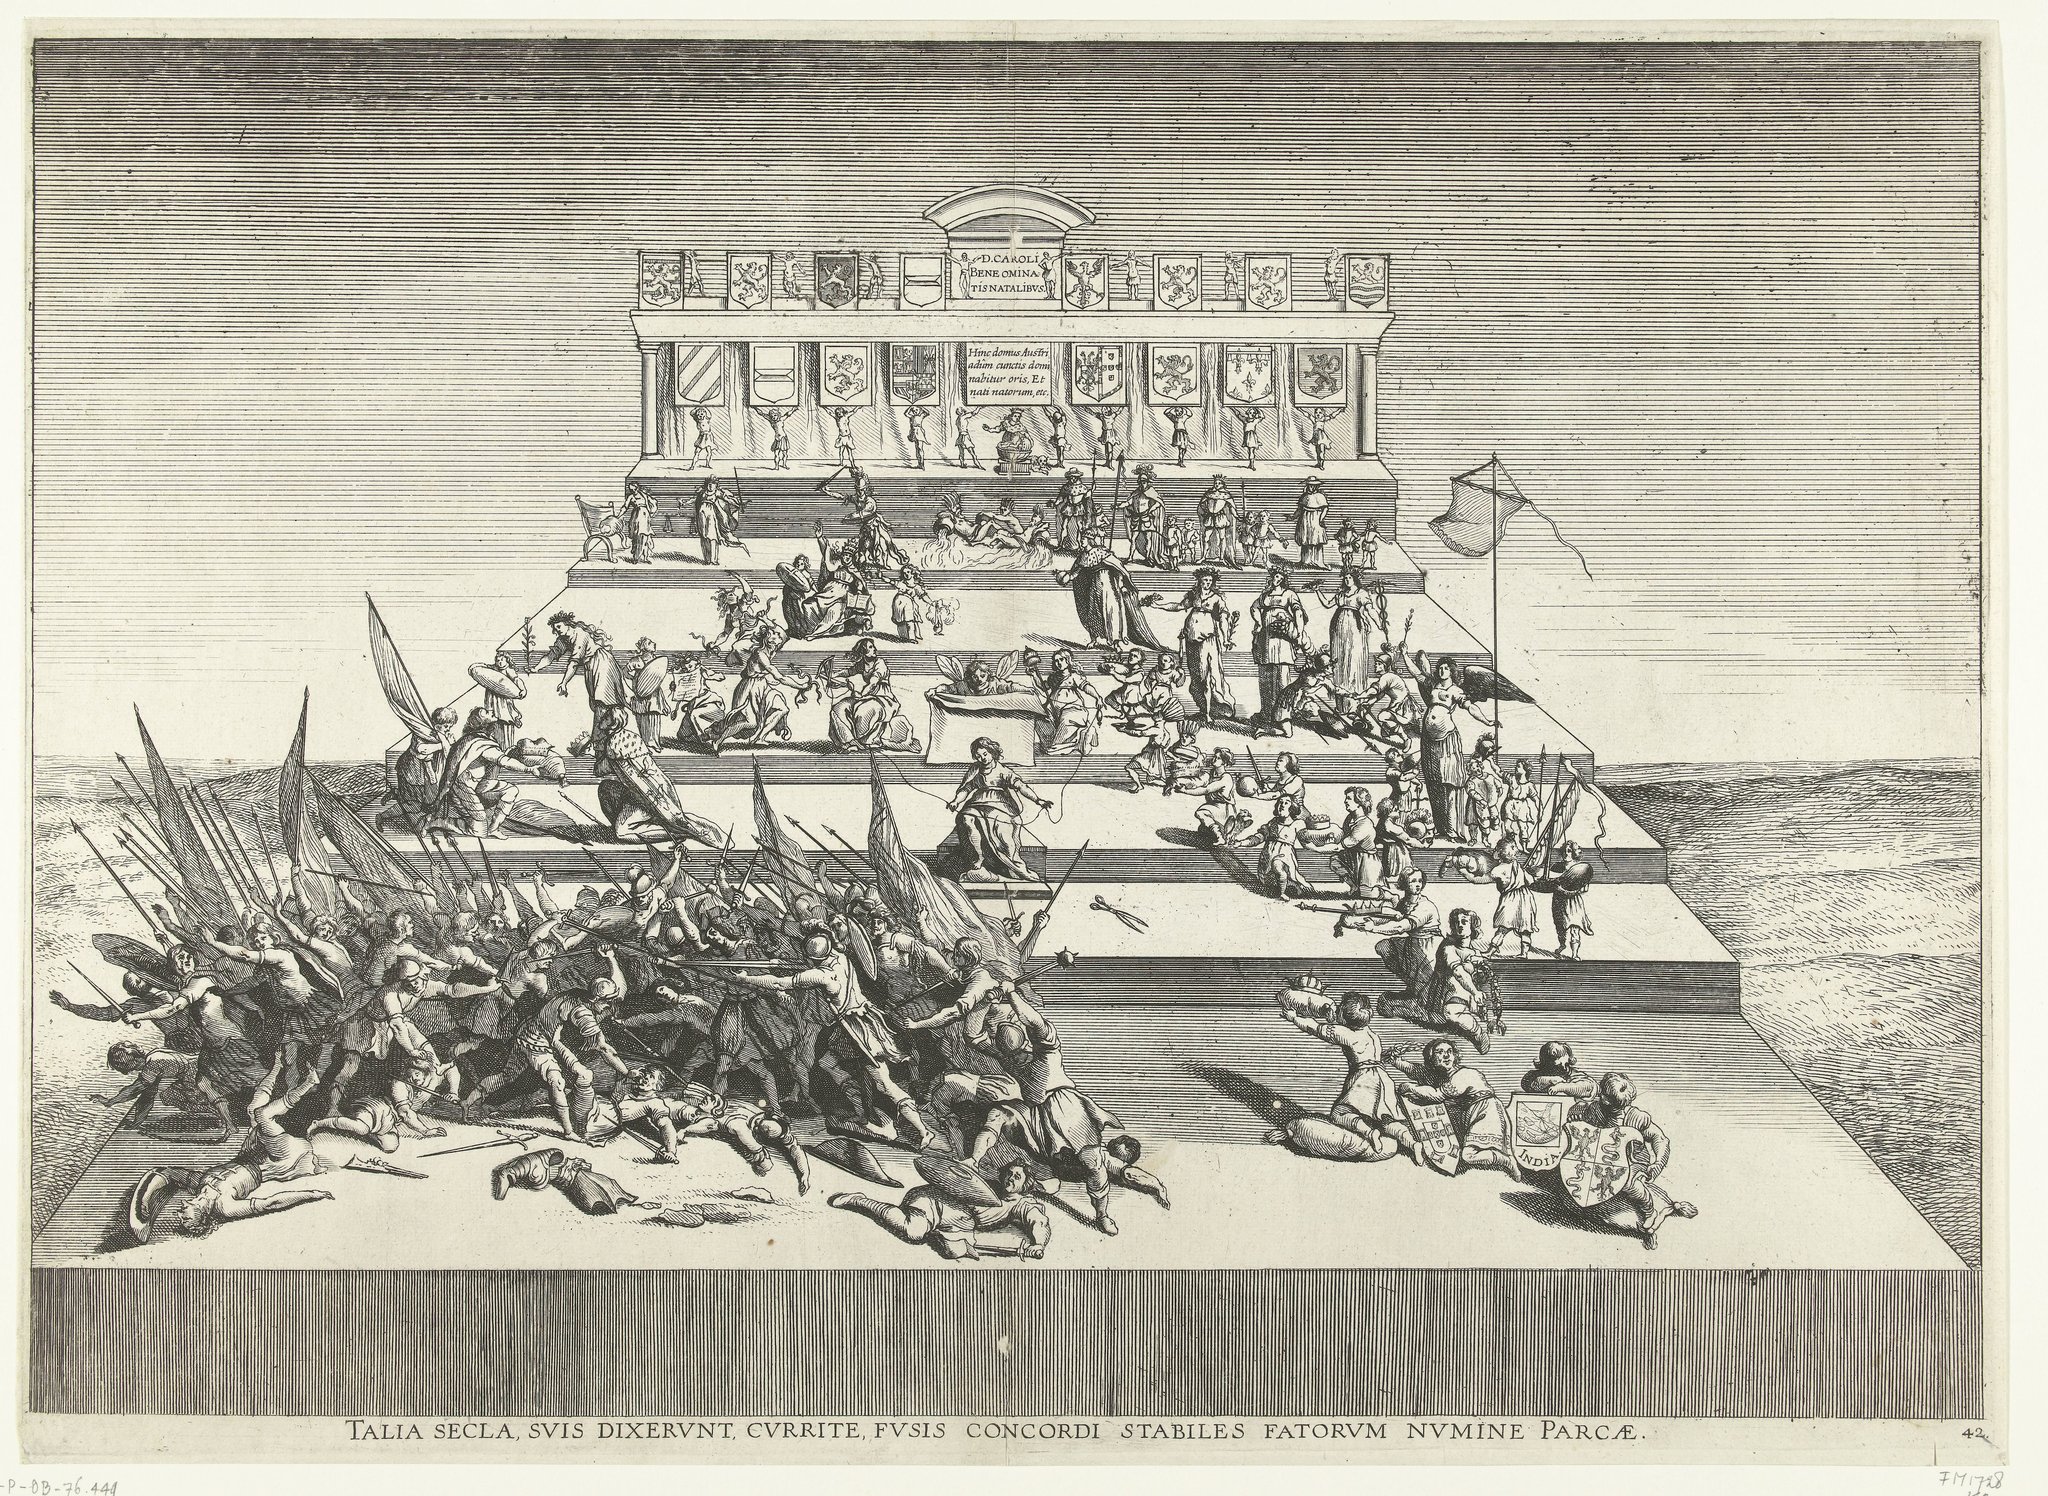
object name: print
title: Theatrum Genethliacon Caroli V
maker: Anonymous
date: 1635-1636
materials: paper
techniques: etching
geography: southern netherlands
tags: ghent, charles v (holy roman emperor and king of spain), brussels, landvoogd der zuidelijke nederlanden ferdinand van oostenrijk, theatre, theatrical performance, triumphal entry and public reception, pageant, 'entrée solennelle', 'joyeuse entrée'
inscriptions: collector's mark: Lugt 240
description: Toneelvoorstelling op een podium voor het Prinsenhof over de chaos van de oorlog en de eendracht en orde hersteld door het bestuur van Karel V en Ferdinand. Tegen de achterwand de wapens van zestien provincies van de Nederlanden. Blad nr. 42 in een geheel van 42 platen die de uitgave van de beschrijving van de intocht van de Kardinaal Infant Ferdinand van Oostenrijk te Gent op 28 januari 1635 als de nieuwe landvoogd voor de Spaanse Nederlanden illustreren.